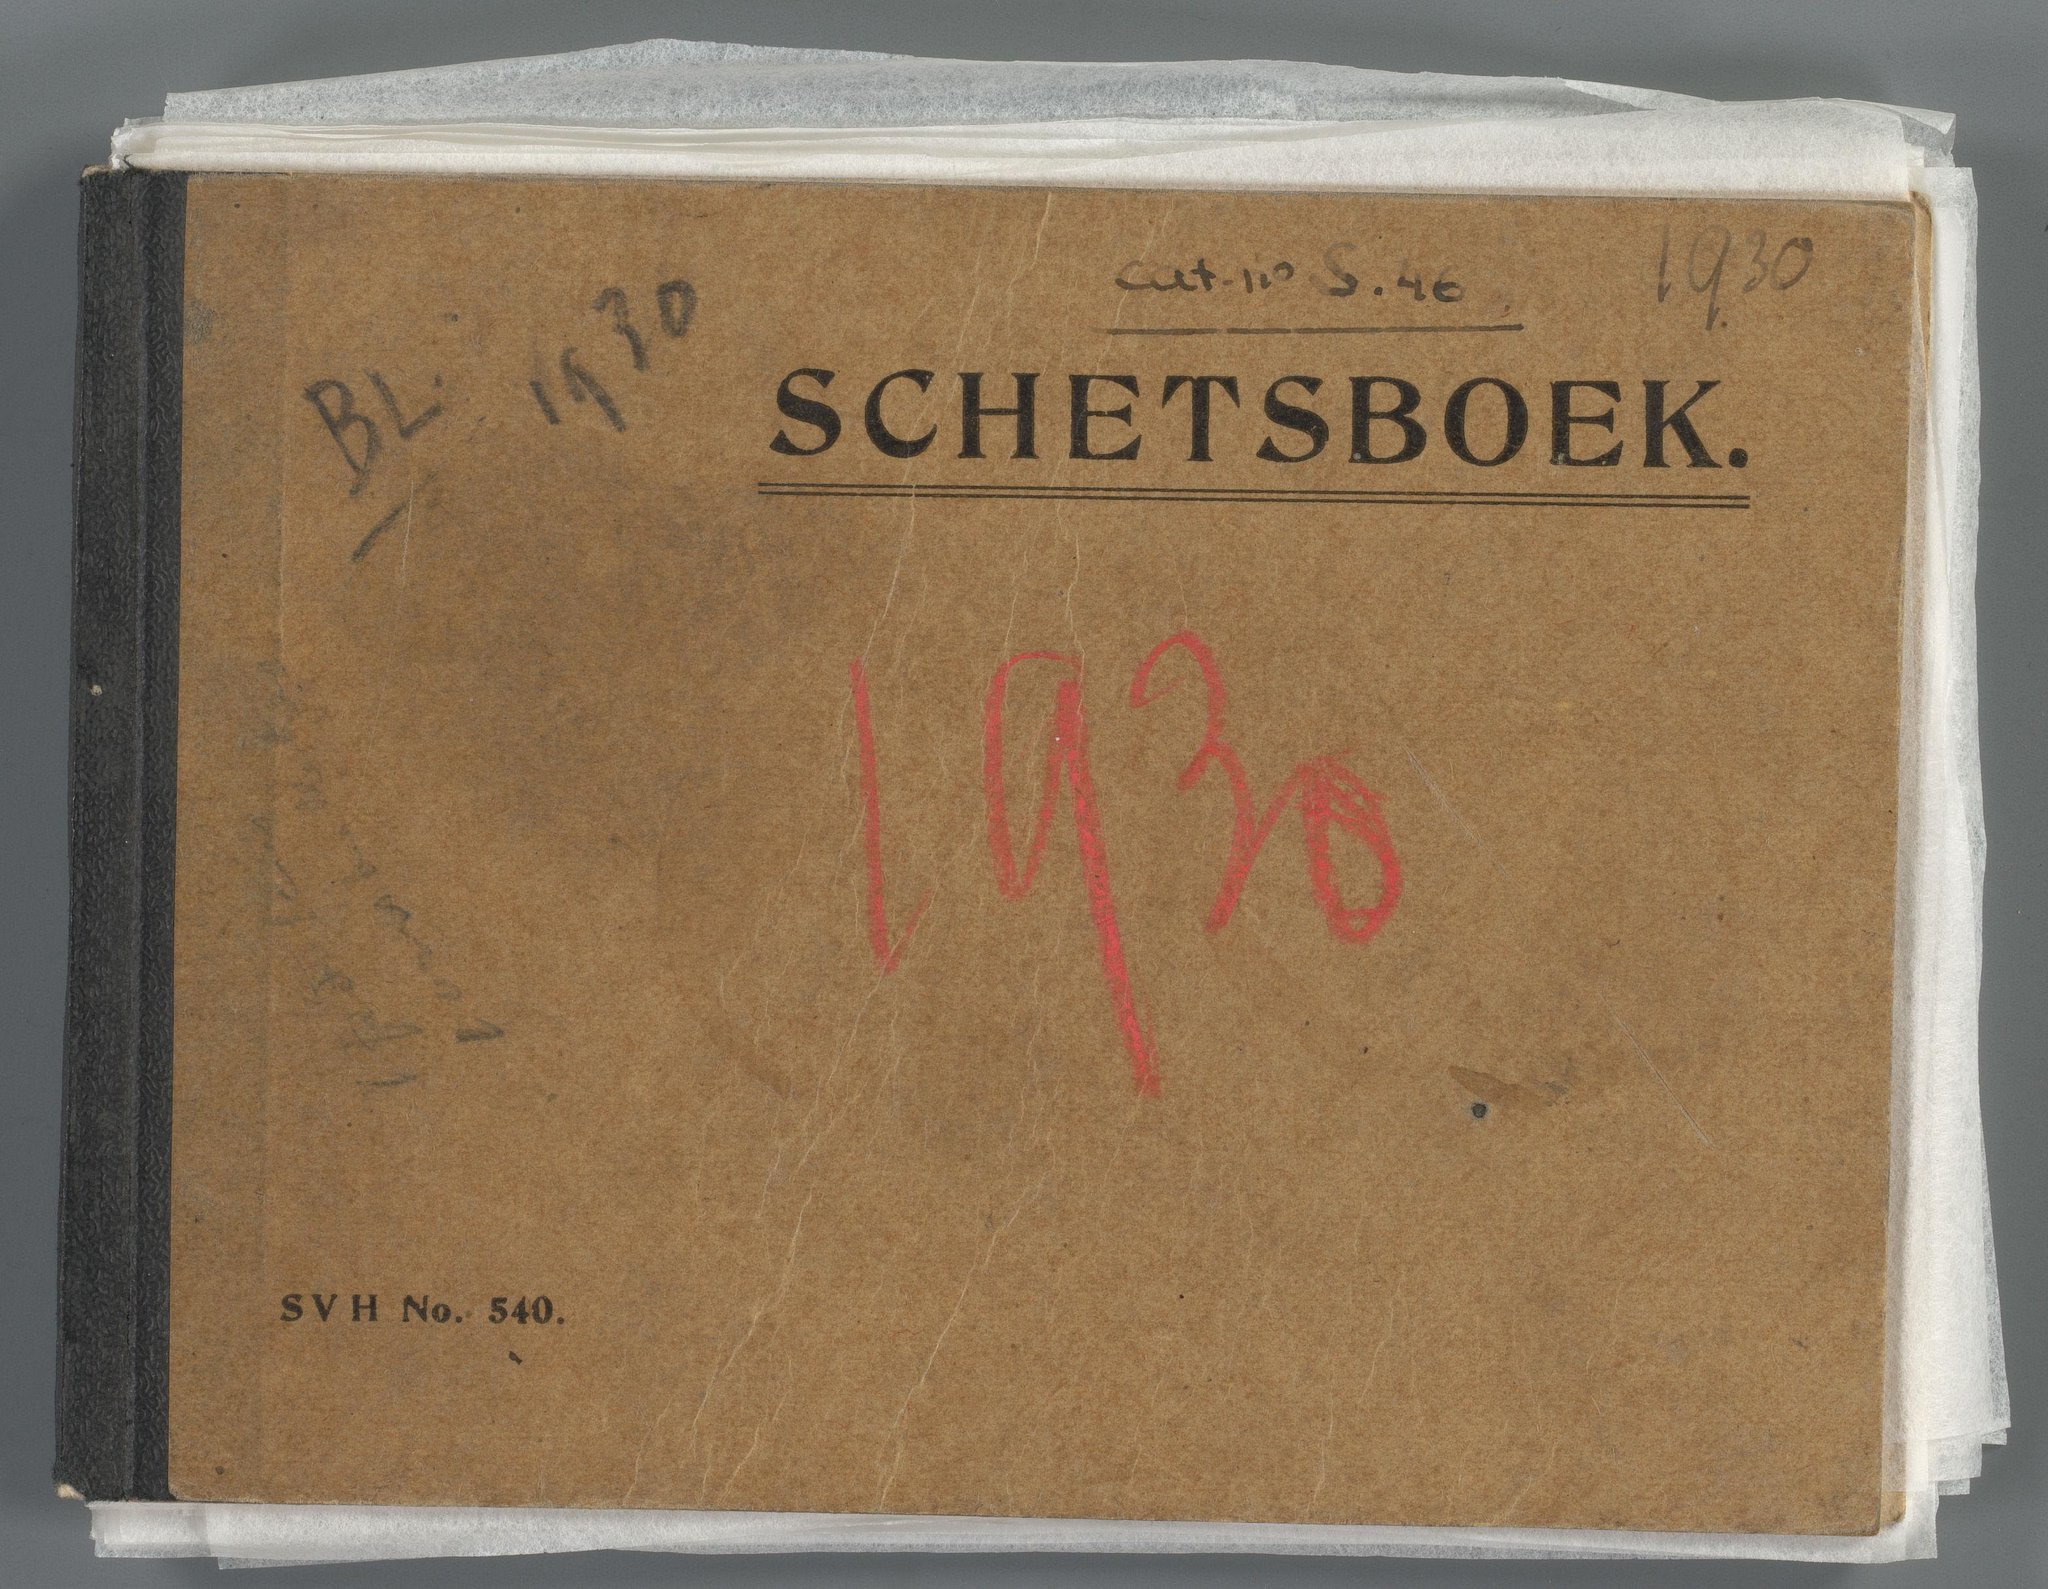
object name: sketchbook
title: Schetsboek Blaricum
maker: leo gestel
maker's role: draughtsman, print maker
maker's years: 1881-1941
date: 1930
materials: cardboard, chalk, ink, paper, pencil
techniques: brush, pen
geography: blaricum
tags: blaricum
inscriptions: workshop stamp: Lugt 1078a, date: ‘1930’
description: Schetsboek bestaande uit 23 bladen met 28 tekeningen van naakten in diverse houdingen, paarden en een vrouw met hoofddoek.